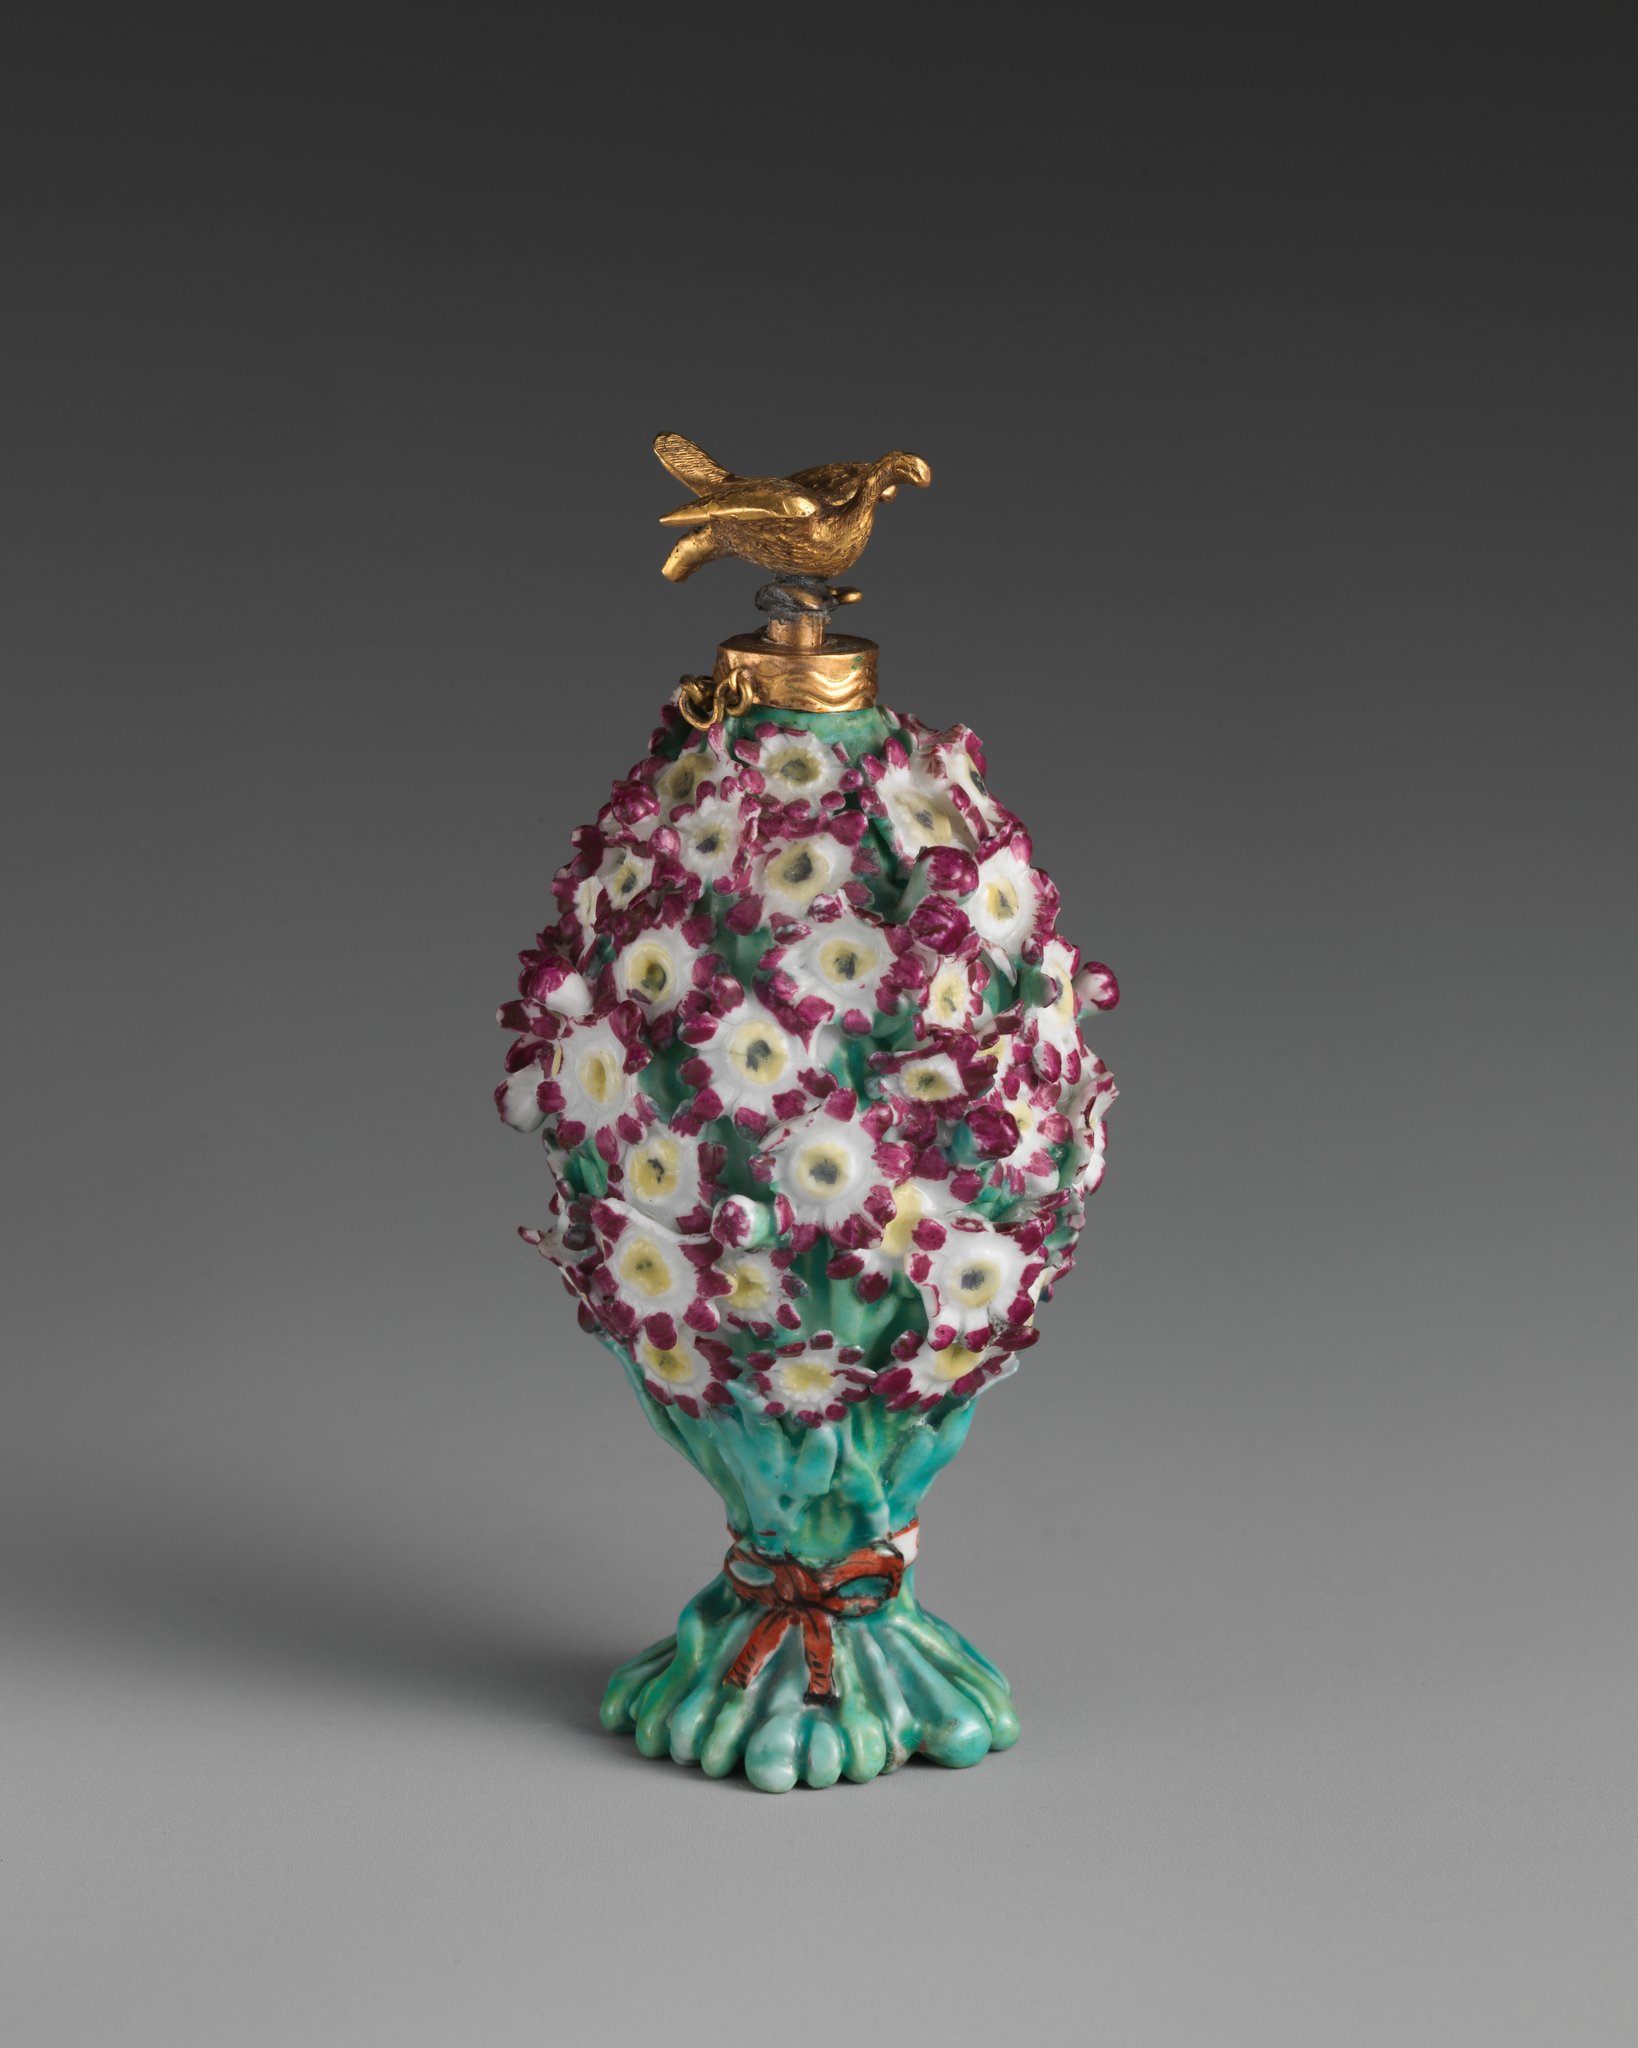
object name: toy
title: Bouquet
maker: chelsea porcelain manufactory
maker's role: factory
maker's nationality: british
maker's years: 1744-1784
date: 1760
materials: soft paste porcelain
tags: birds,flowers